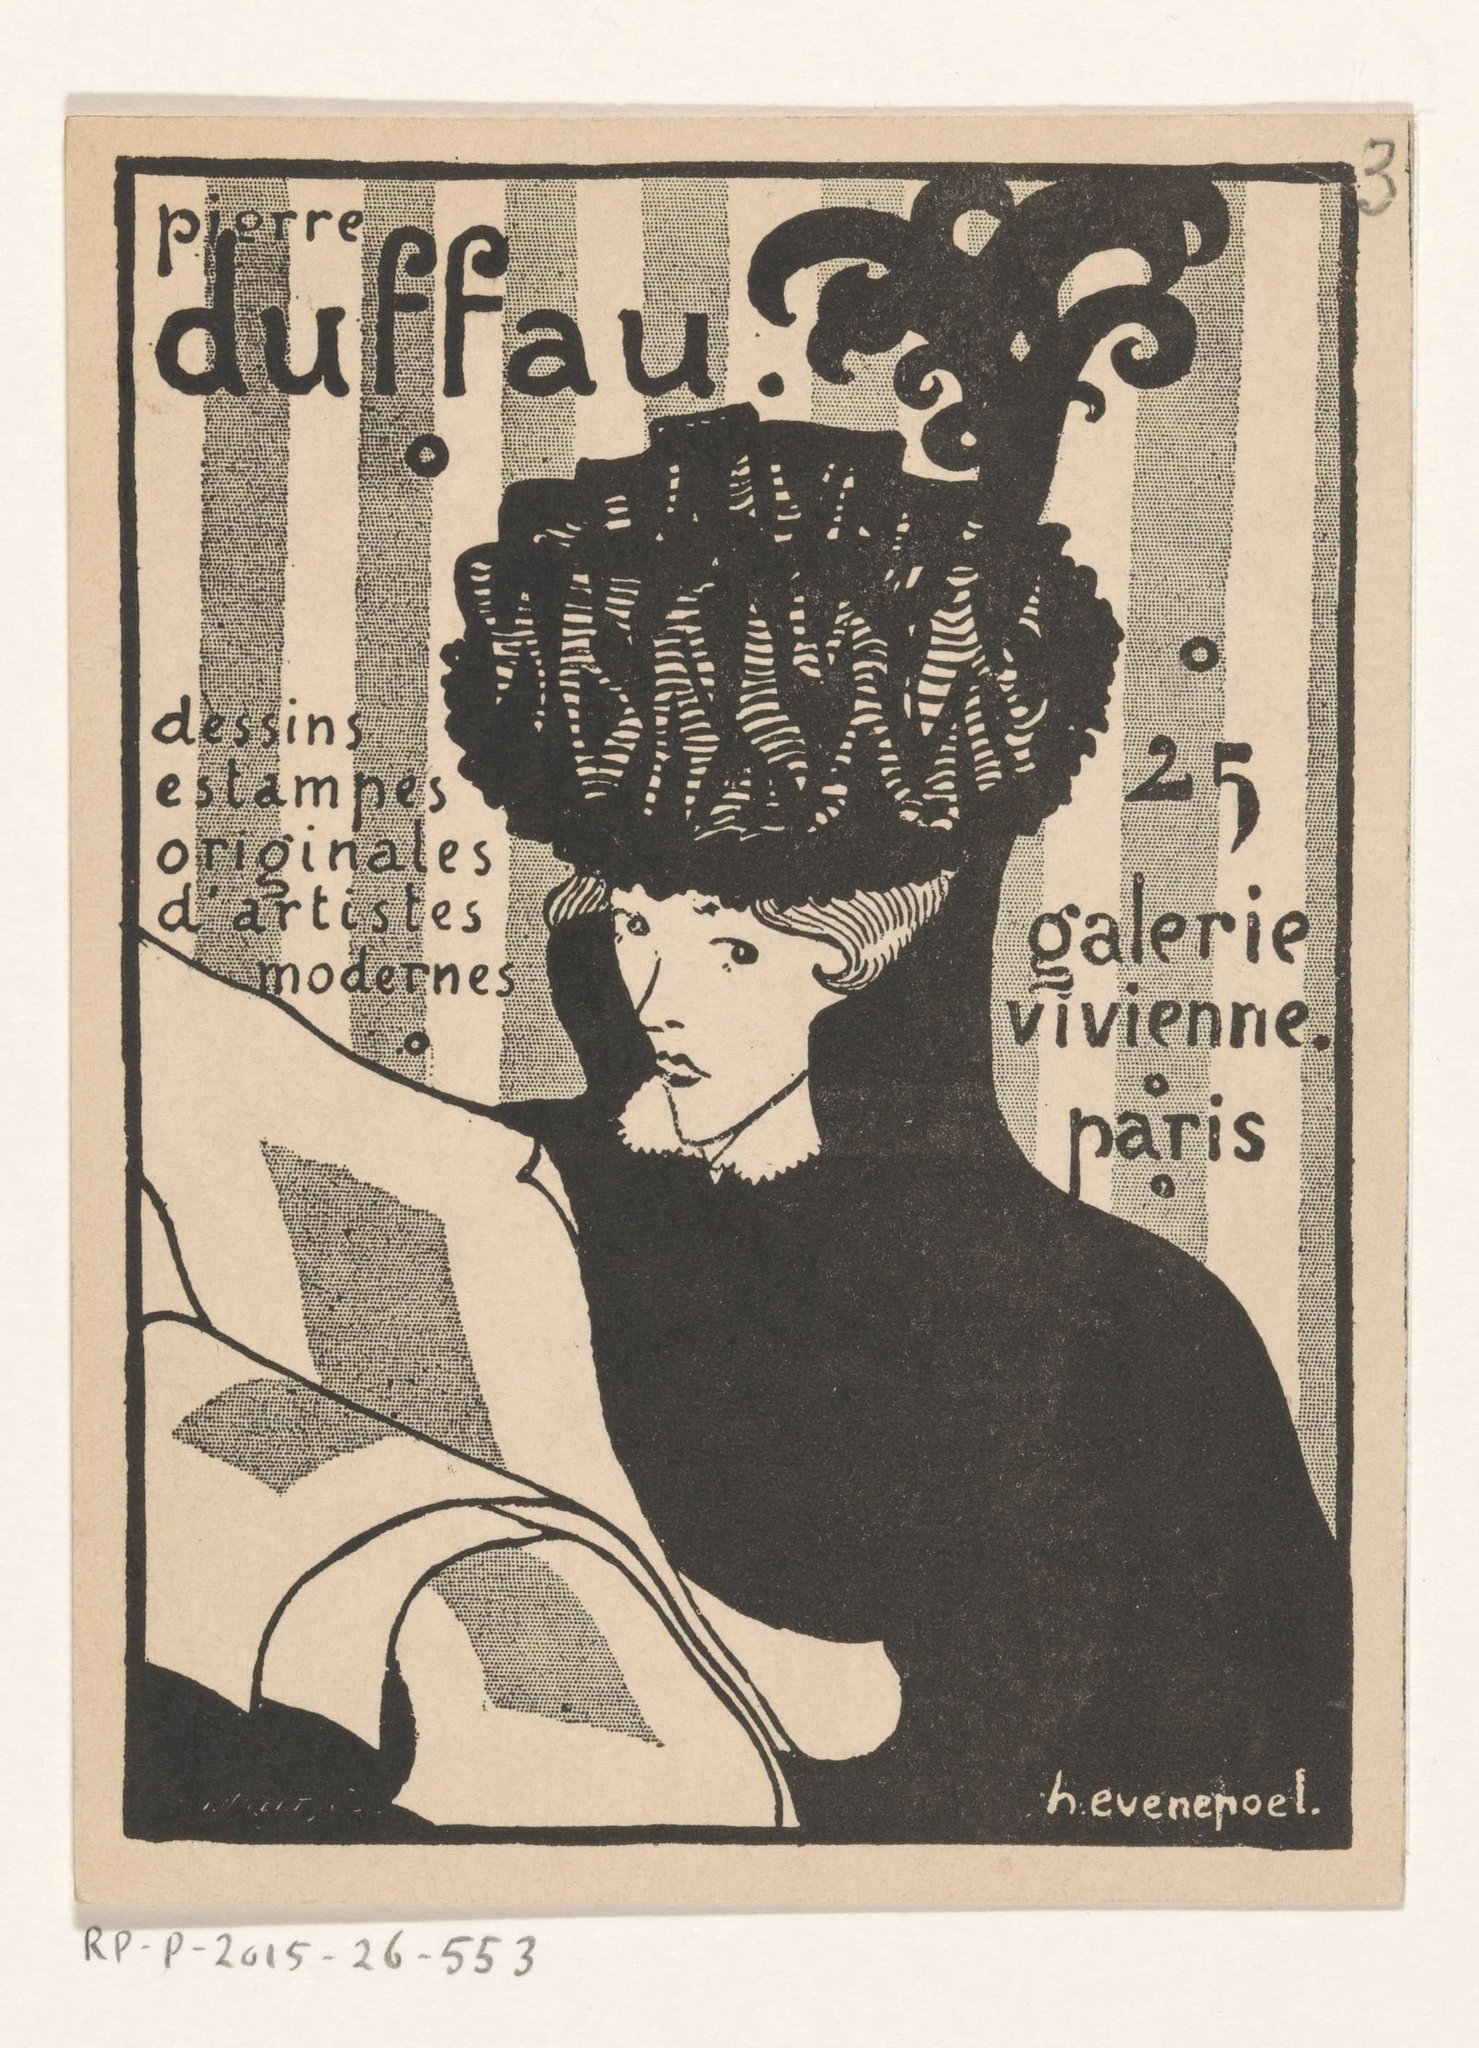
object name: visiting card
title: Visitekaartje van kunsthandelaar Pierre Duffau te Parijs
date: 1882-1899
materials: paper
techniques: lithograph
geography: paris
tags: print, e.g.: engraving, etching, lithograph, art collecting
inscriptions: collector's mark: Lugt 2228, collector's mark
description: Op verso wordt vermeld dat het aanbod onder meer lithografieën van Charles Dulace, gypsografieën van Pierre Roche en steengoed van Dalpayrat en Lesbros bevat.